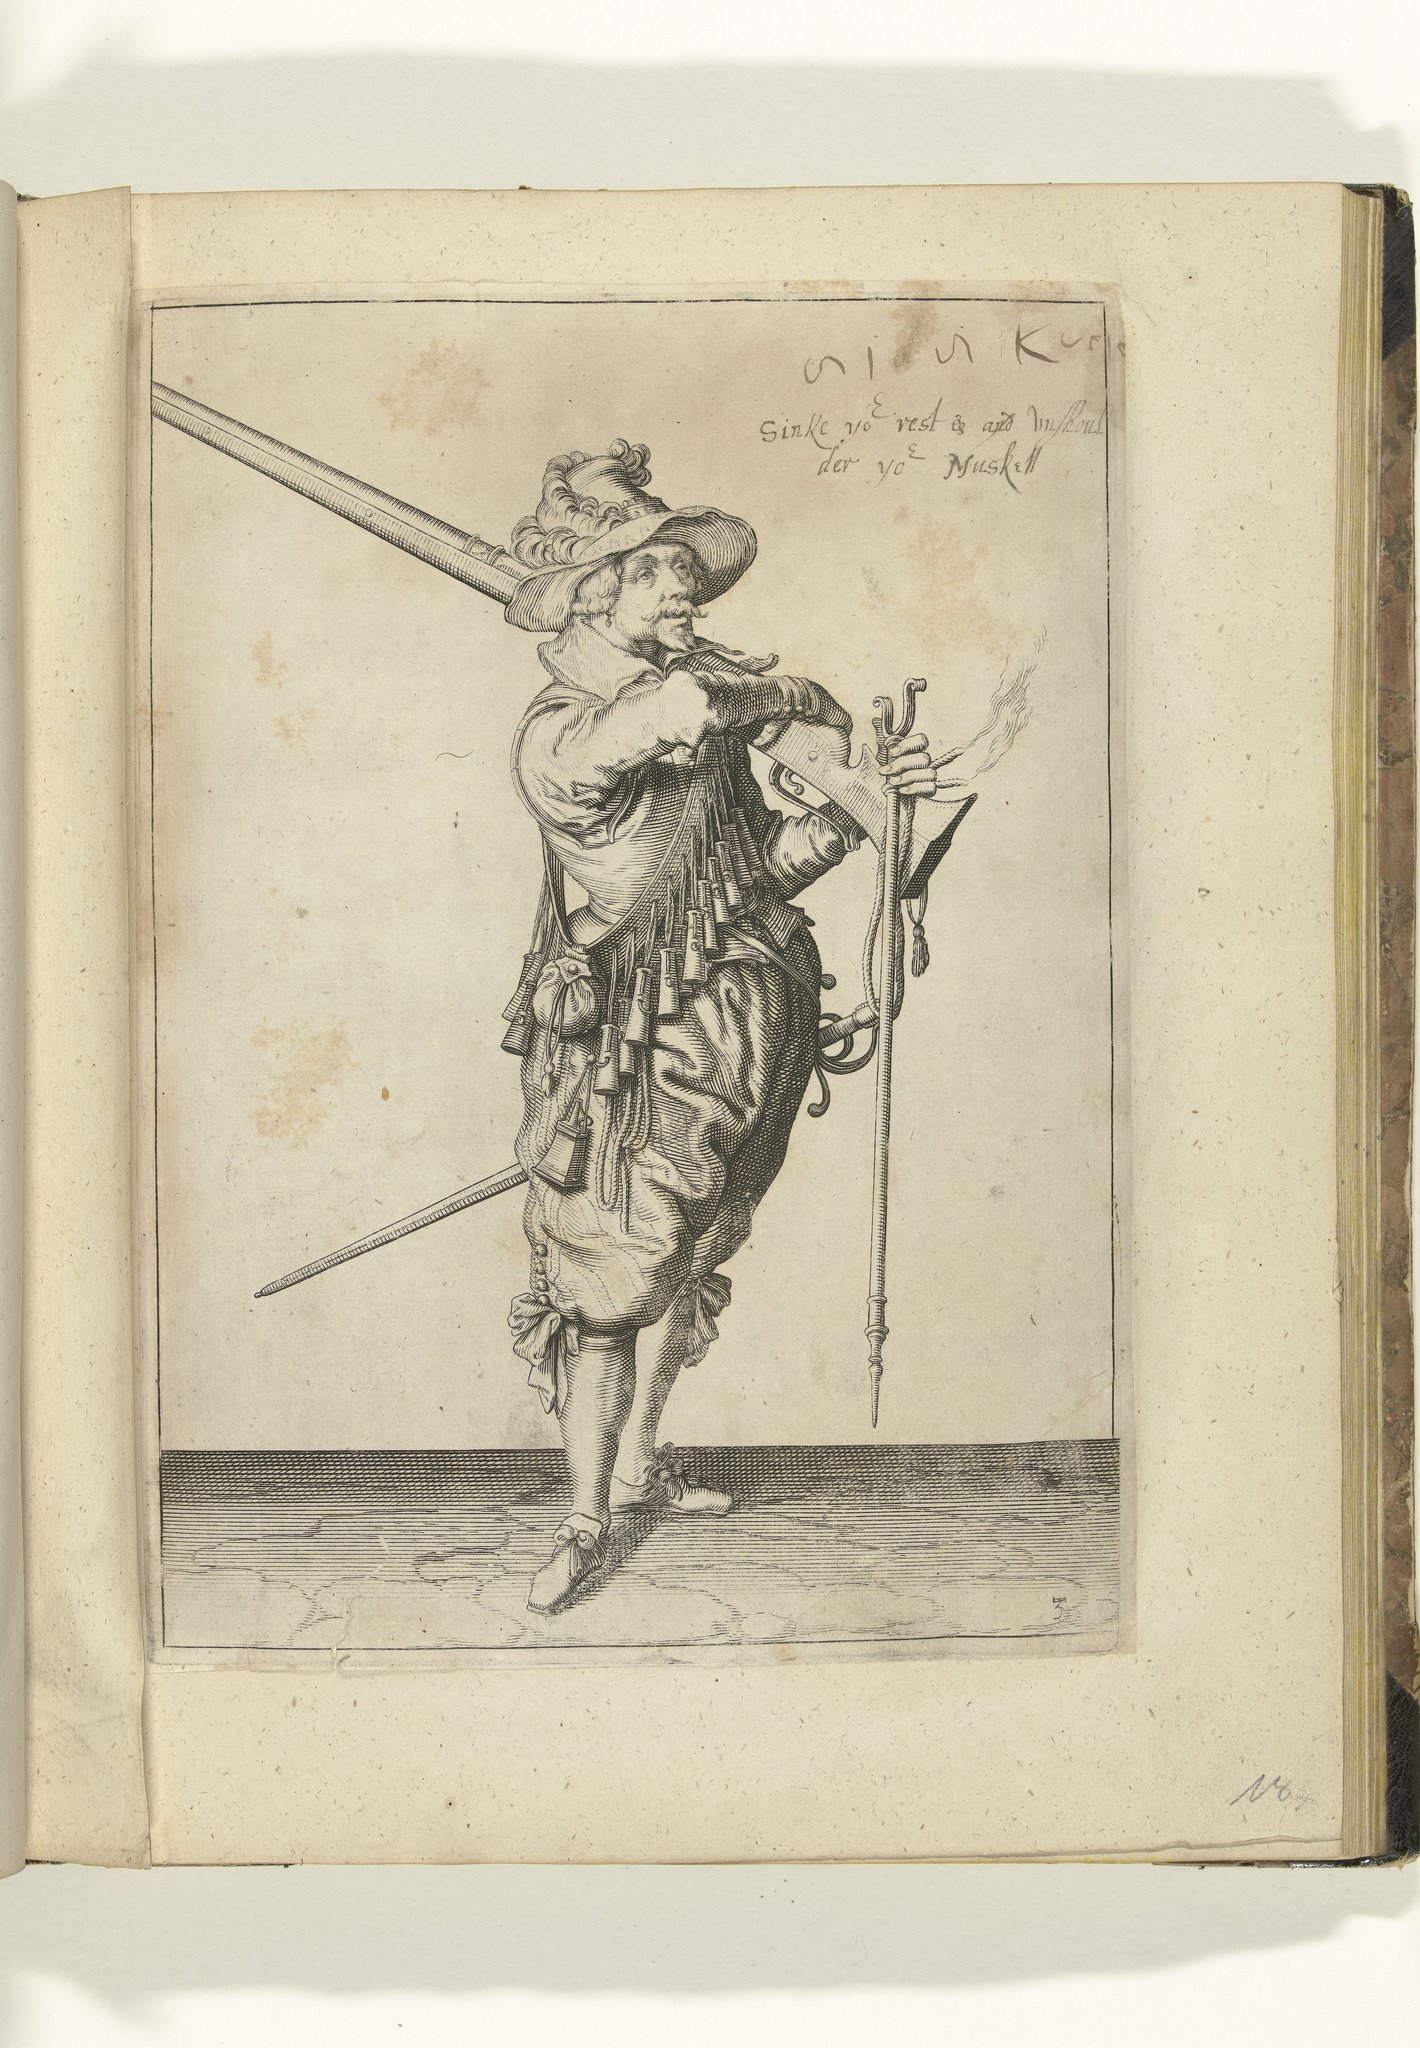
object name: print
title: Soldaat die zijn musket van zijn schouder neemt (nr. 3), ca. 1600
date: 1597-1608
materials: paper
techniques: engraving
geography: northern netherlands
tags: maurice (prince of orange), handling of weapons ~ military training, weapons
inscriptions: inscription: ‘Sinke ye rest and unshoulder ye Muskett’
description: Een soldaat, ten voeten uit, naar rechts, die een musket (een bepaald type vuurwapen) van zijn linkerschouder neemt met zijn rechterhand (nr. 3), ca. 1600. In zijn linkerhand behalve de kolf van het musket ook een furket (musketvork) en een brandende lont. Plaat 3 in de instructies voor het hanteren van het musket: Shorte instruction for the figures, so much concerneth the right use of muskett. Onderdeel van de illustraties in een Engelse editie van J. de Gheyns Wapenhandelinghe: J. de Gheyn, The exercise of armes for calivres, muskettes and pikes after the ordre of Maurits Prince of Orange, 's-Gravenhage 1608. Krijgswezen rond 1600.